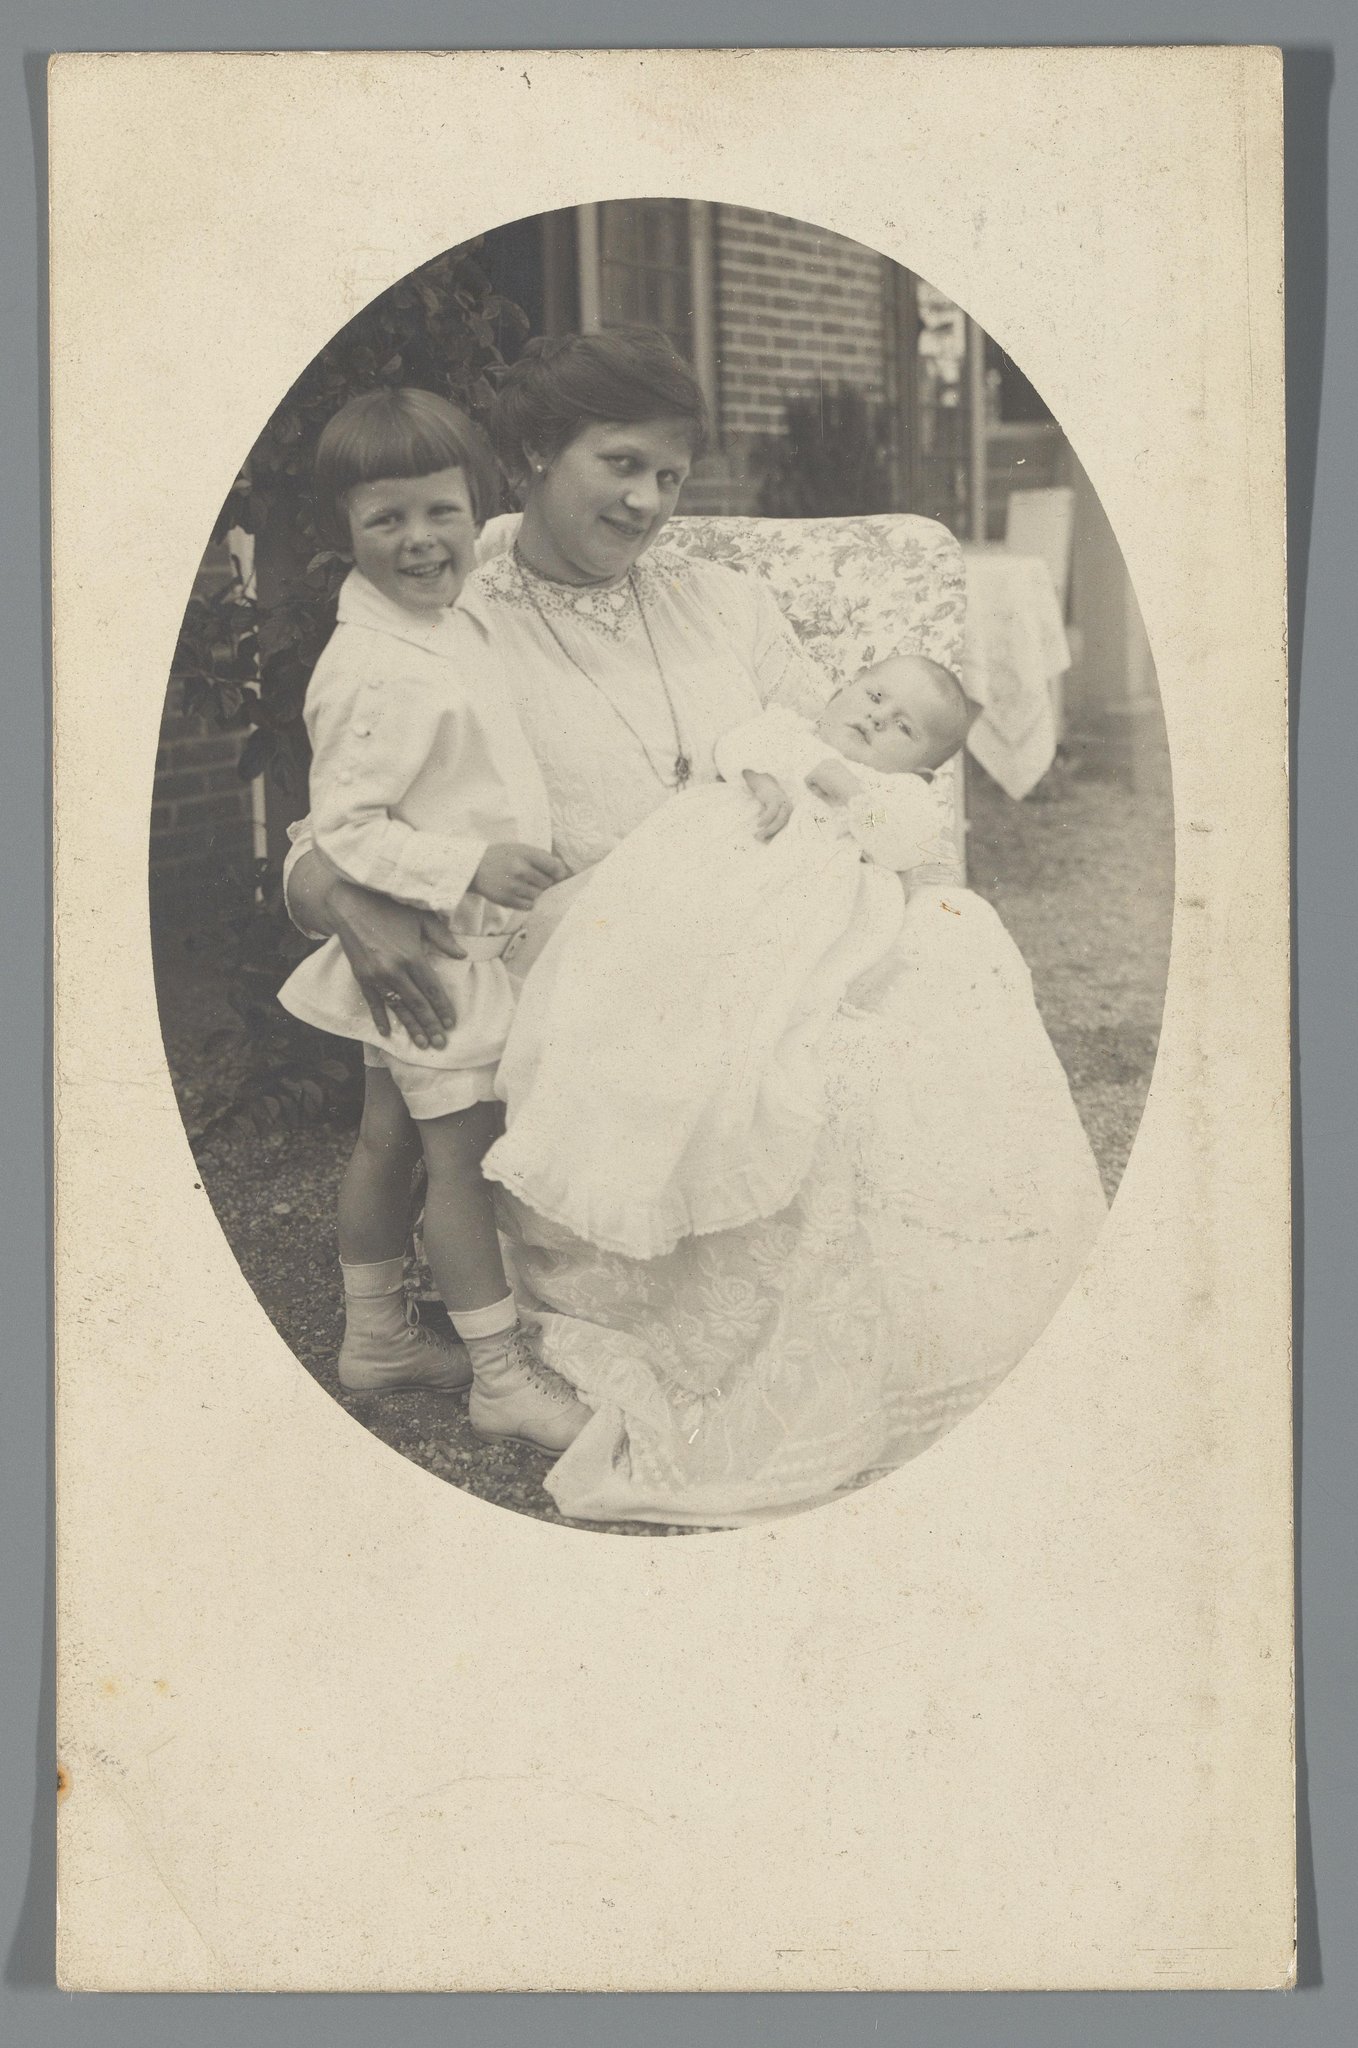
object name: photograph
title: Line van den Berg met twee kinderen in ovaal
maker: Anonymous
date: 1910-1913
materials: photographic support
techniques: photography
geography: netherlands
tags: the hague, caroline louise van den berg-van den berg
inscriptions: seal, inscription, stamp